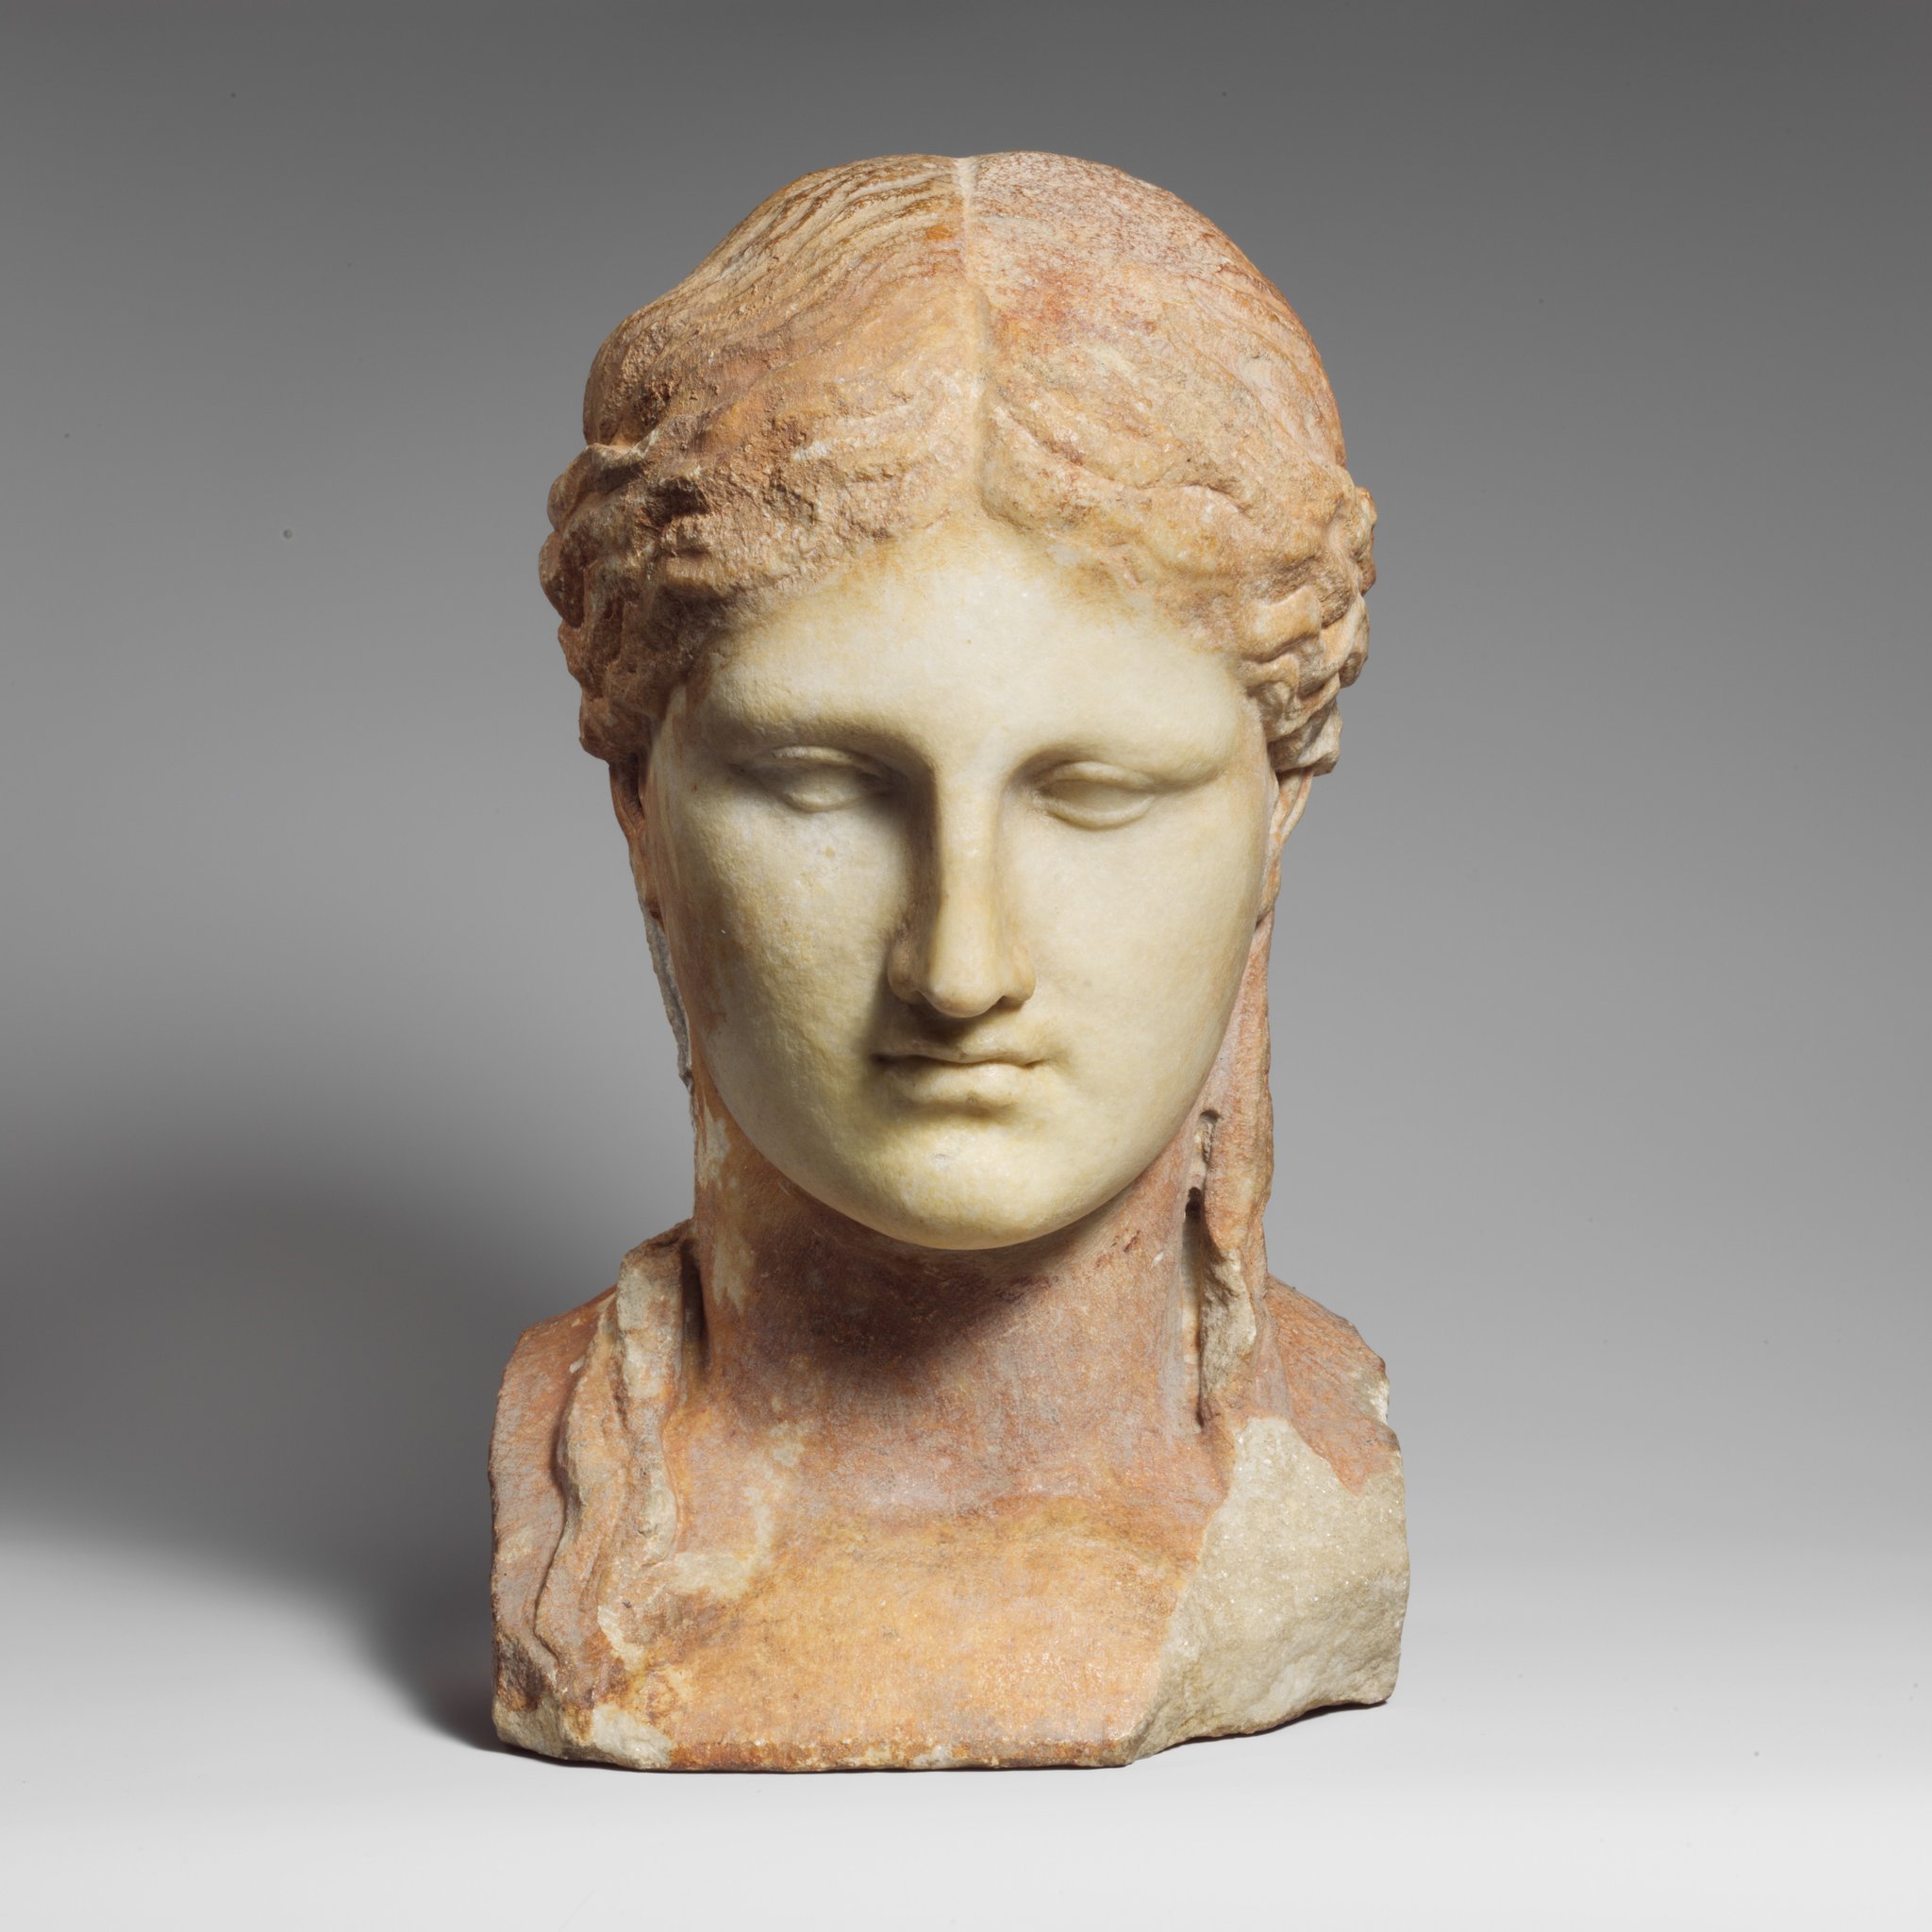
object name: herm of a woman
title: Marble female herm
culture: roman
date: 1-100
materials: marble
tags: heads,women